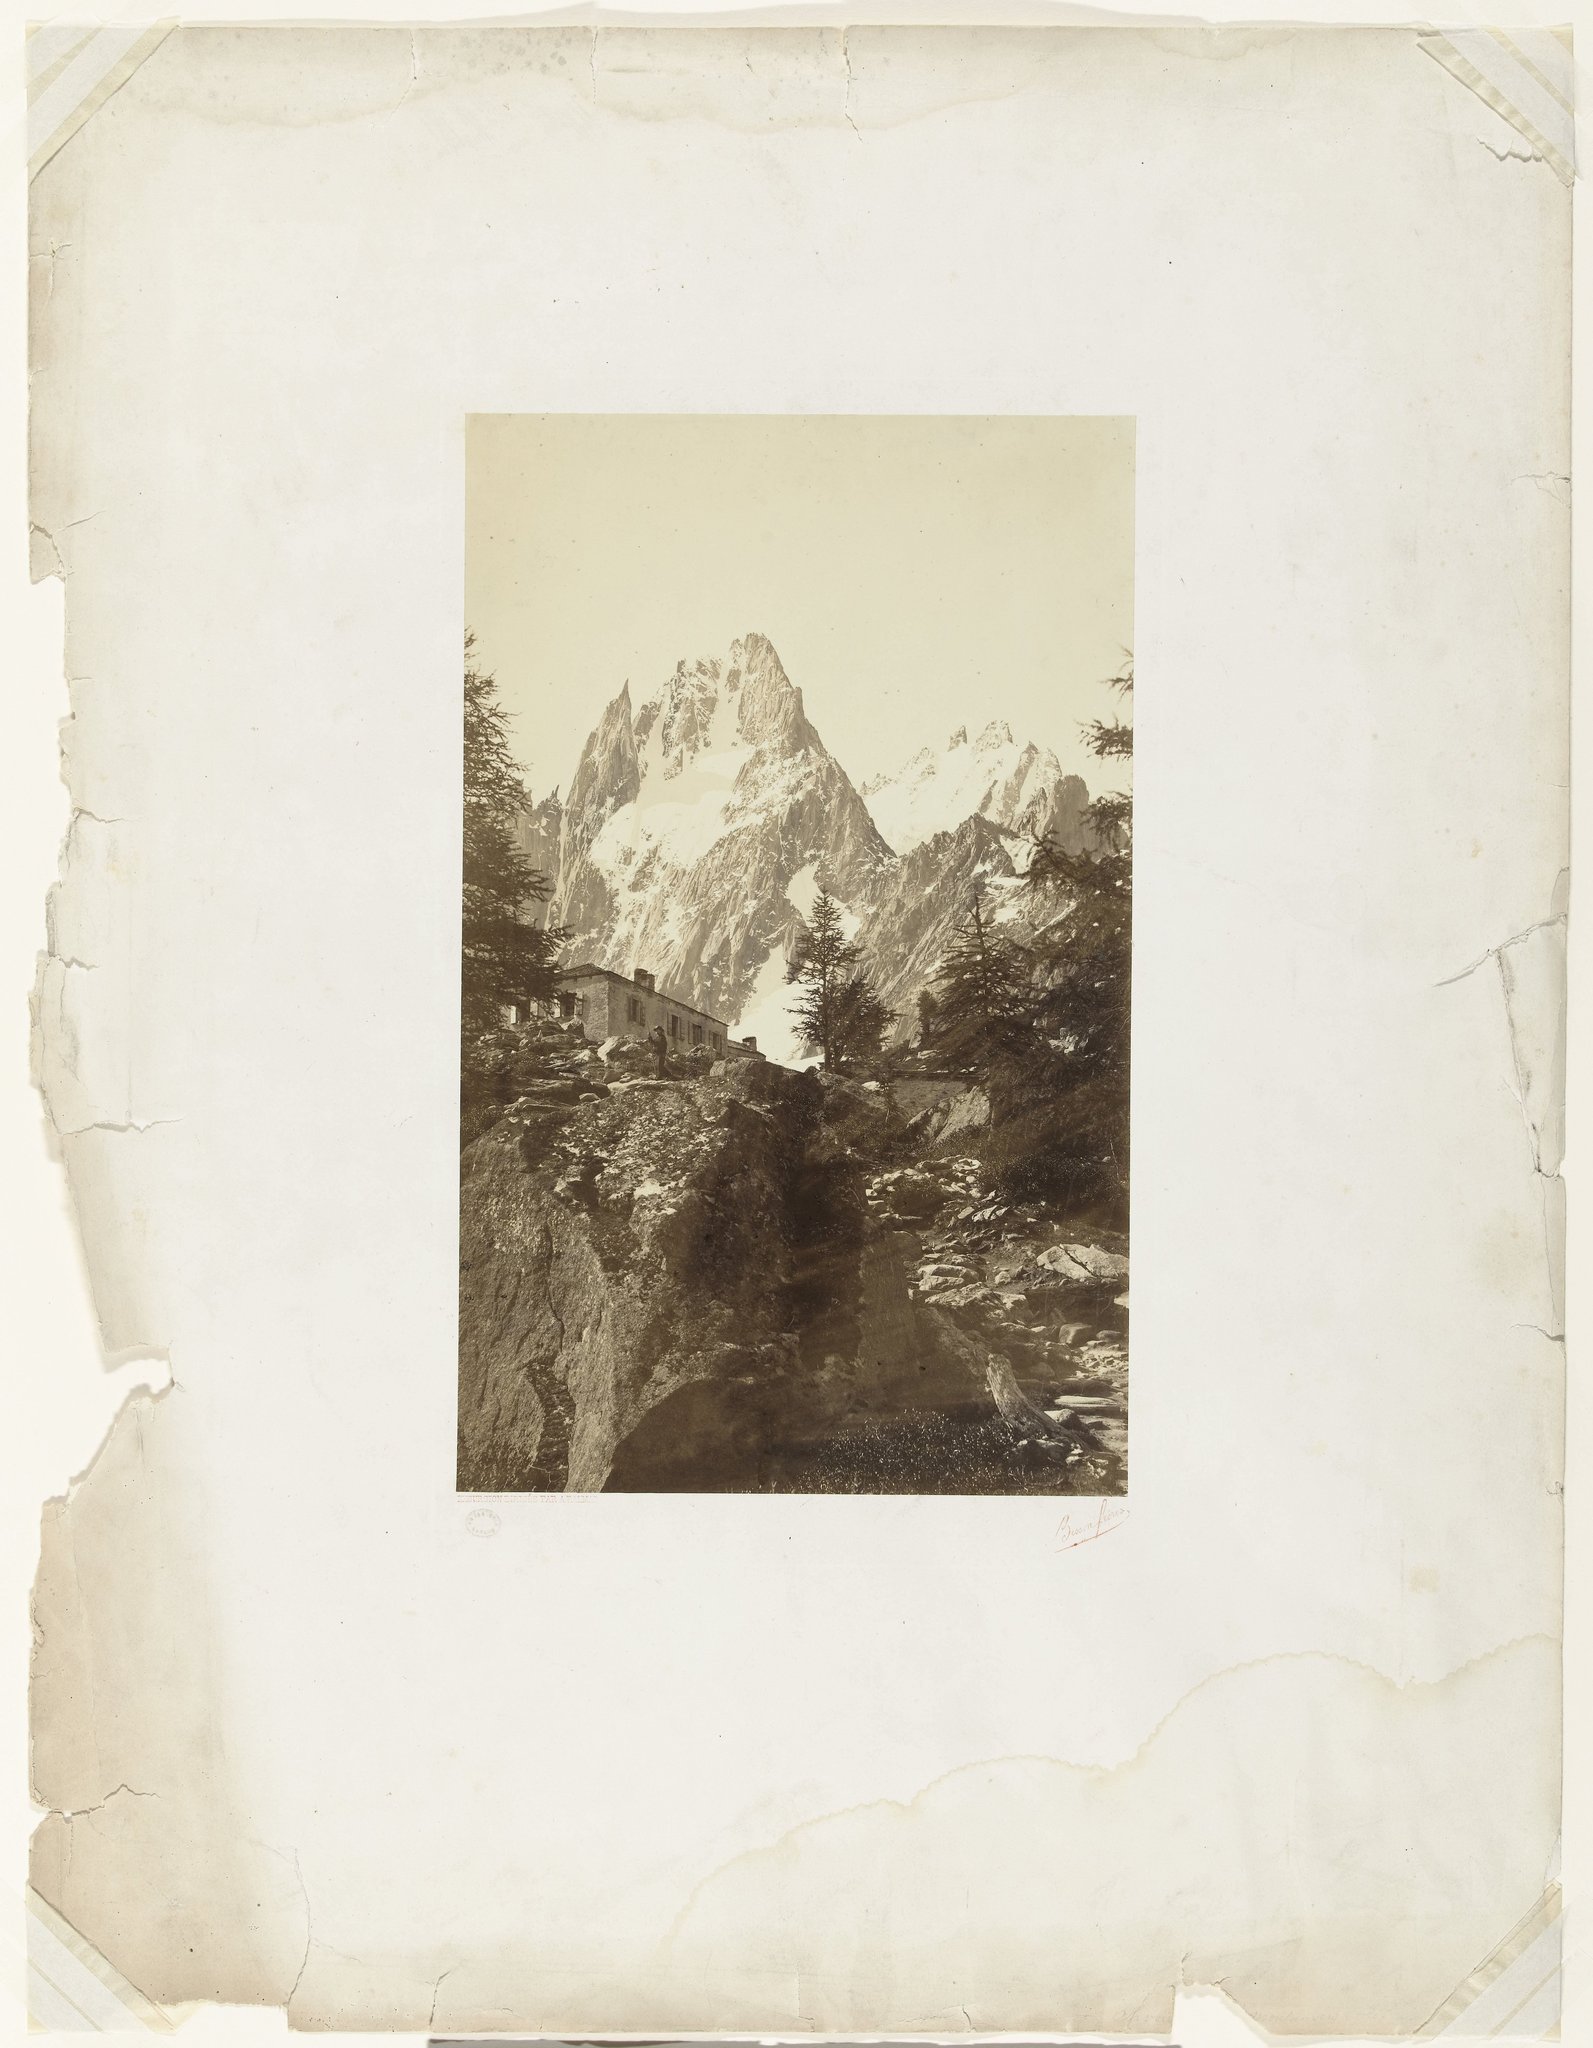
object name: photograph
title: Alpenlandschap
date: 1861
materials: cardboard, photographic support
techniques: albumen print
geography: france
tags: mountains